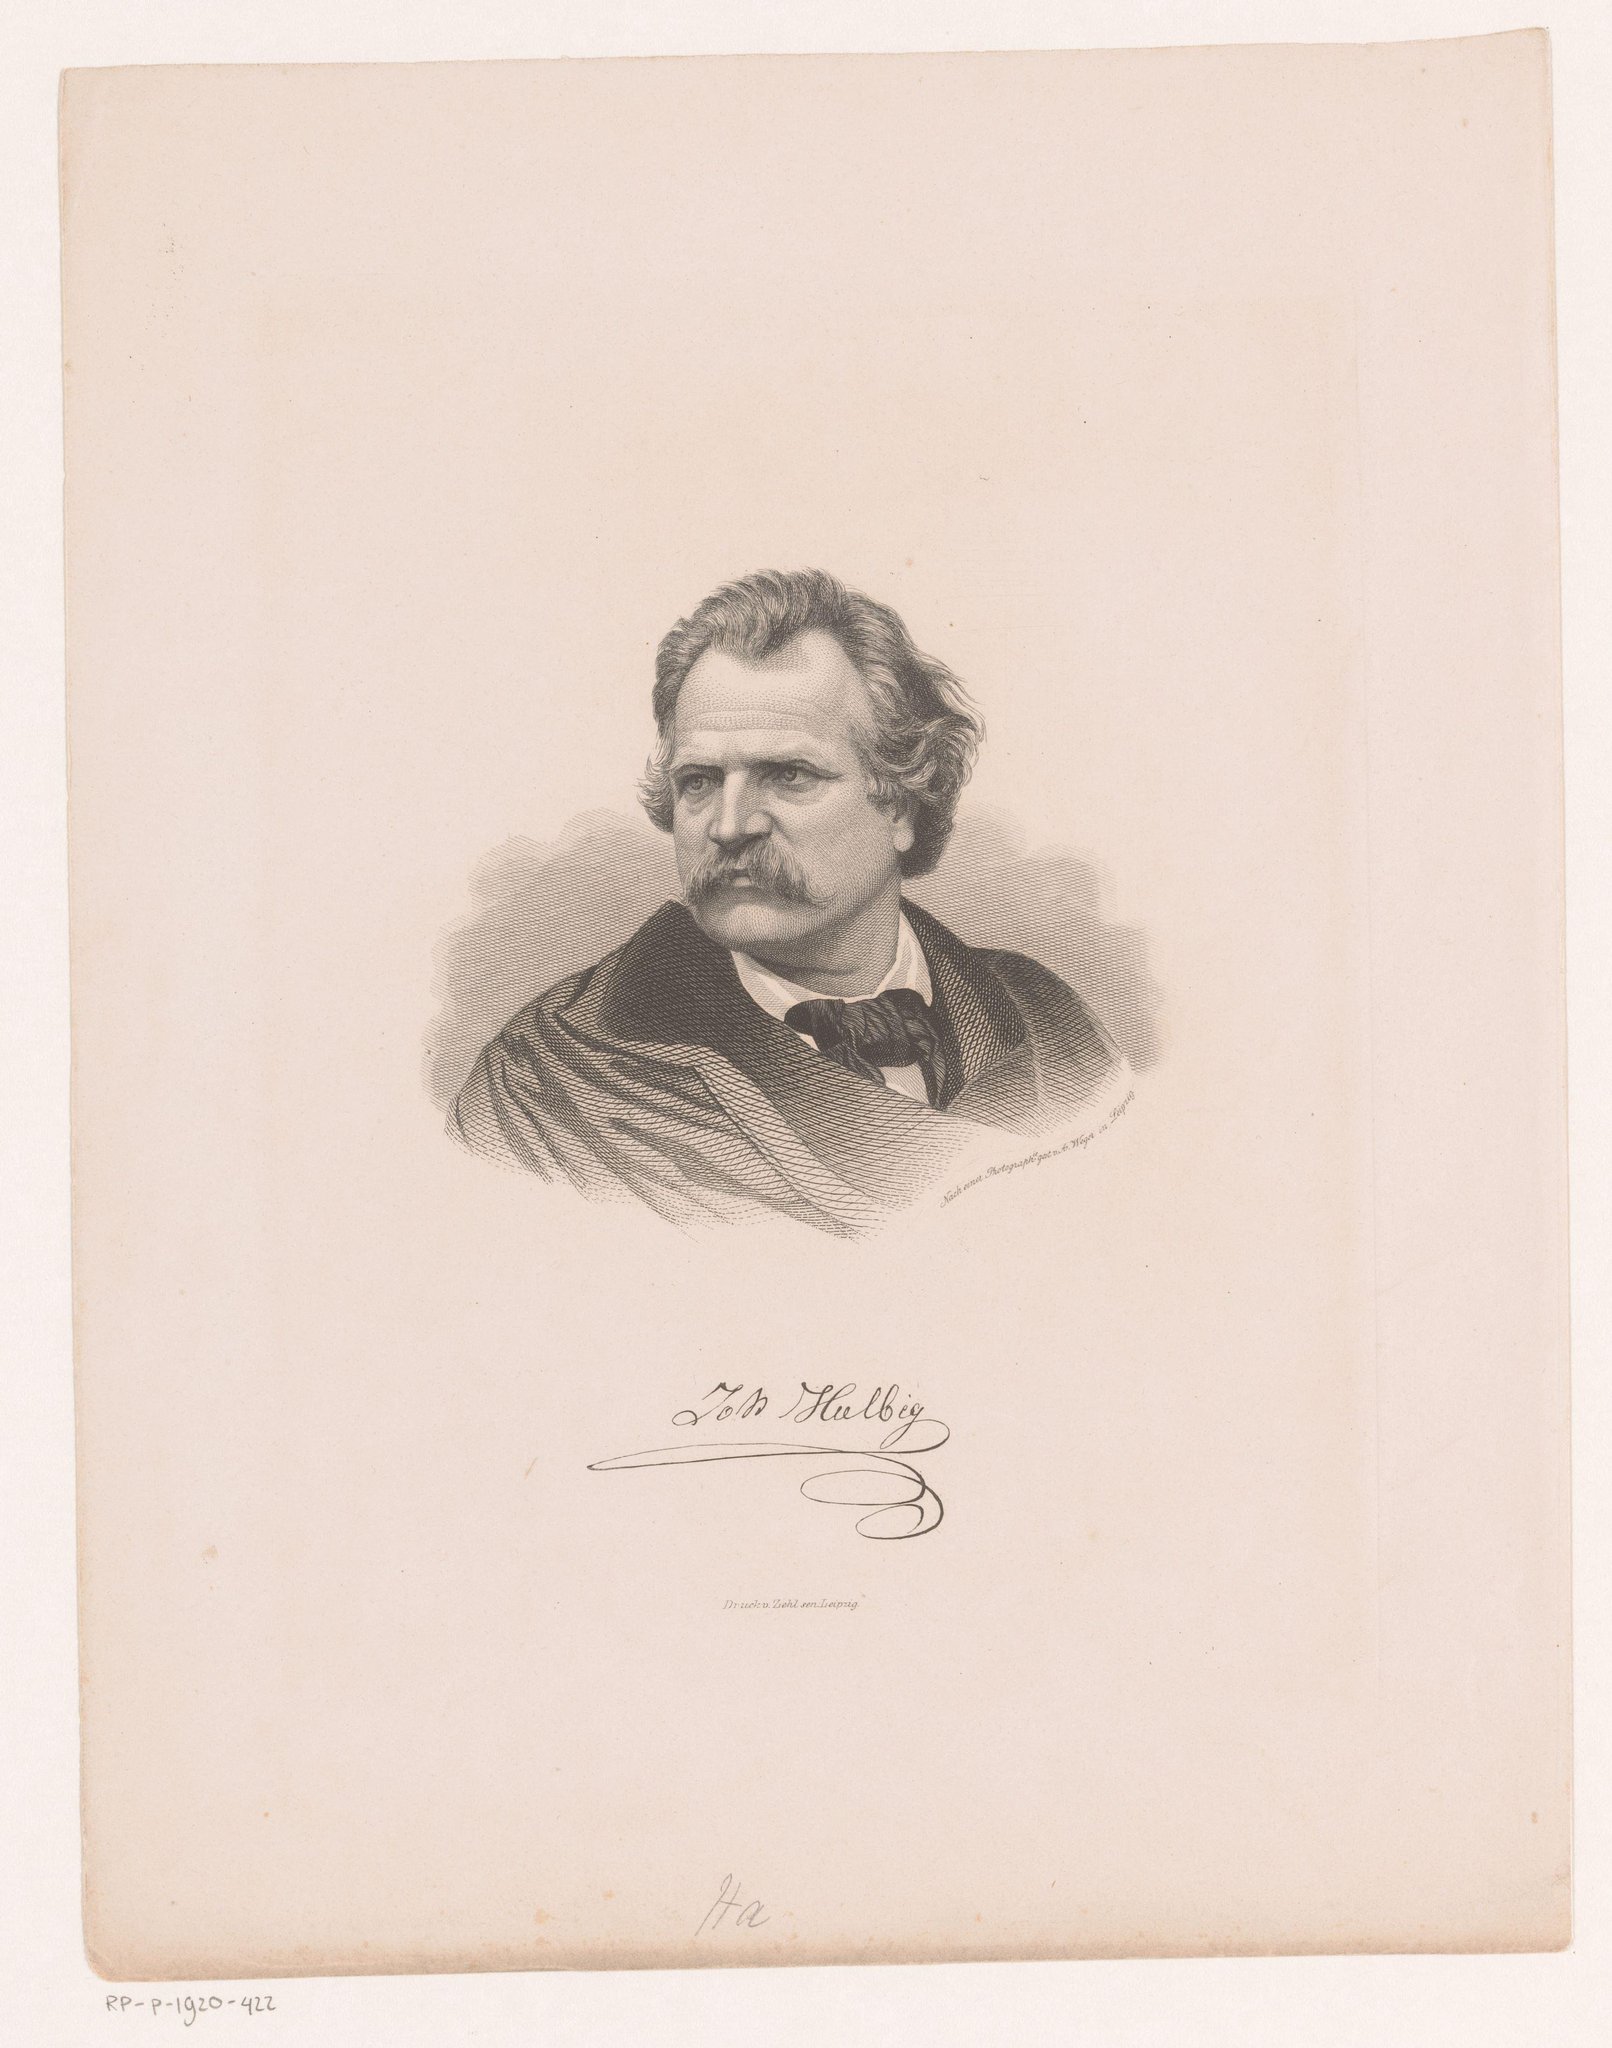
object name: print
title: Portret van Johann von Halbig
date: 1849-1892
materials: paper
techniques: engraving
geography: leipzig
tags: sculptor, johann von halbig, historical persons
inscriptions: collector's mark: Lugt 2228